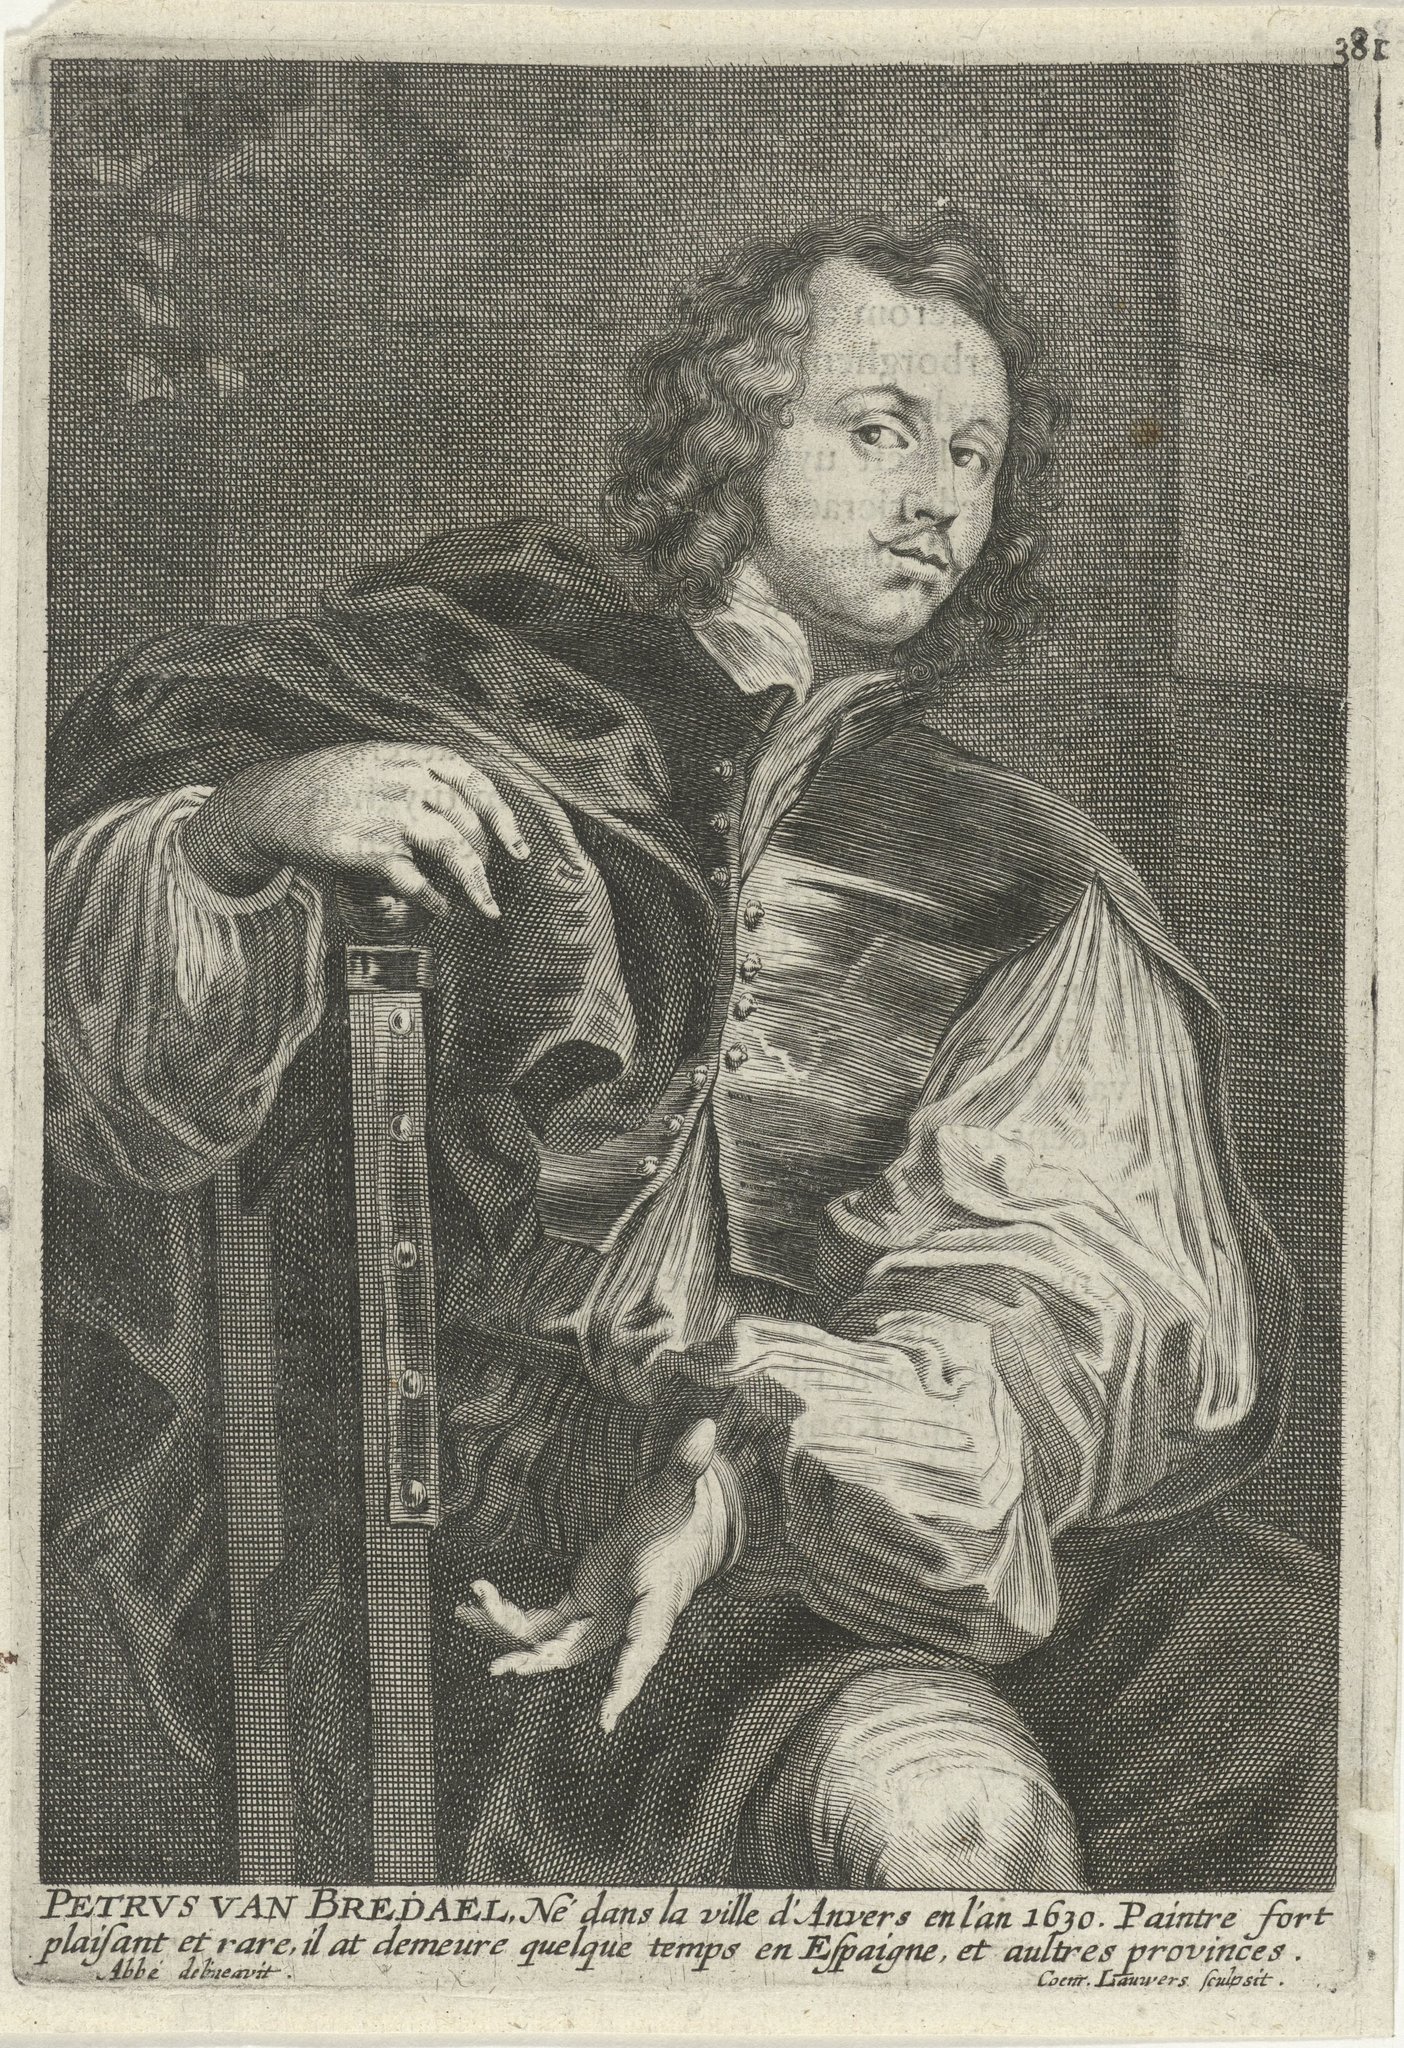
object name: book illustration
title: Portret van Peeter van Bredael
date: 1662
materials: paper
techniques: engraving, letterpress printing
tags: painter, draughtsman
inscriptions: collector's mark: Lugt 2228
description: Portret van Peeter van Bredael, tekenaar en schilder. Kniestuk, zittend op een stoel met zijn rechterarm over de stoelleuning. In de marge staat een tweeregelig onderschrift in het Frans. Prent rechtsboven gemerkt: 381.